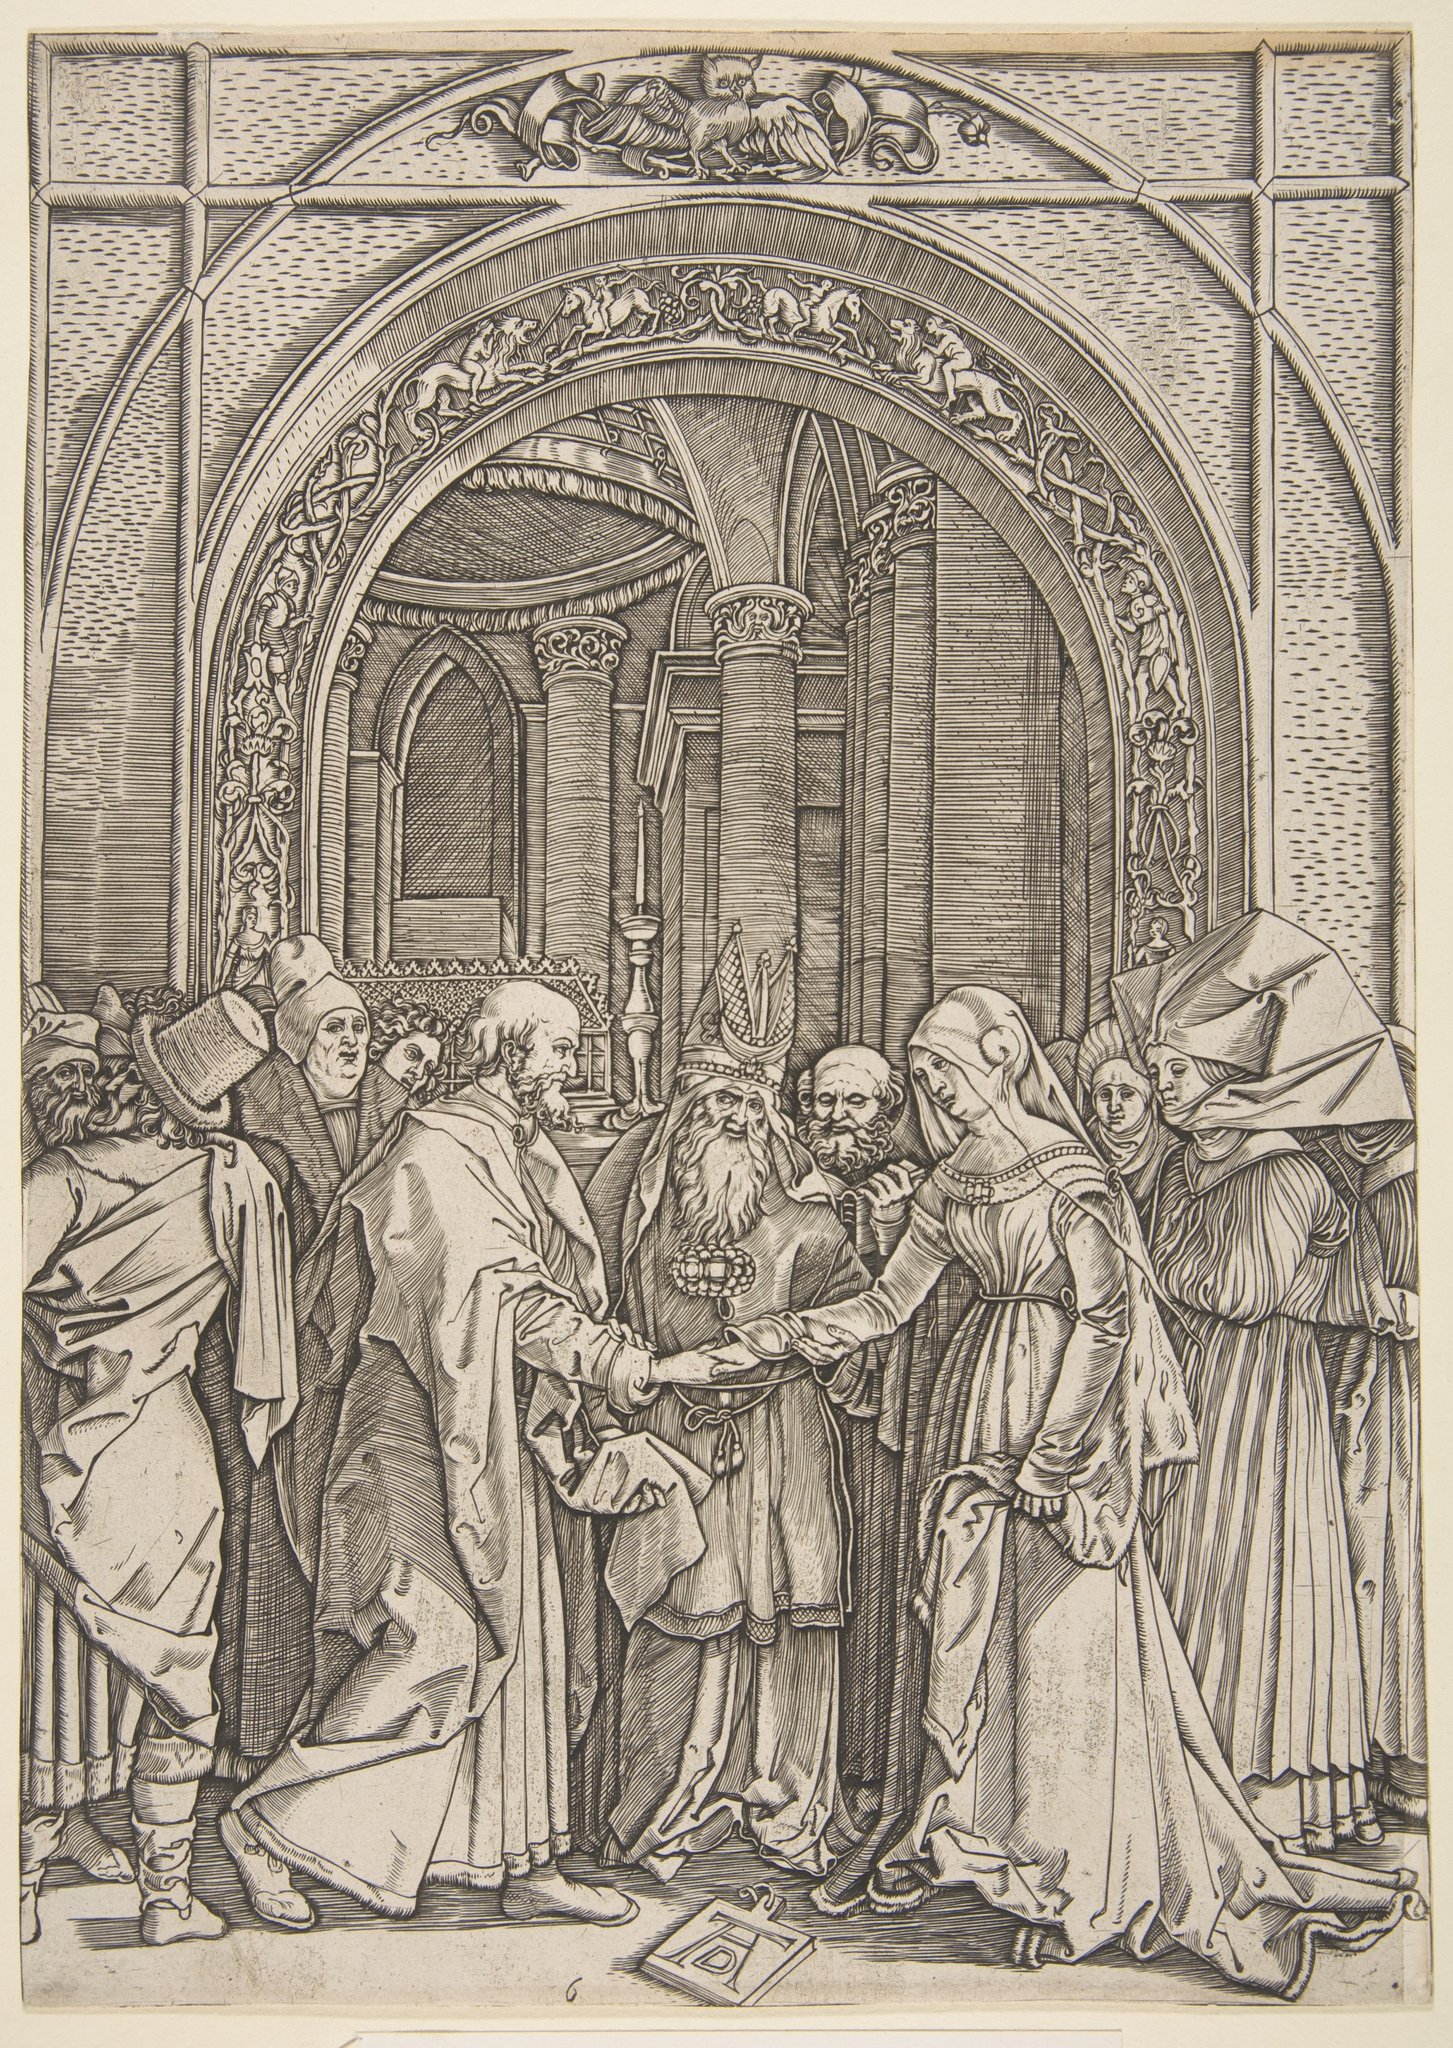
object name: print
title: The Betrothal of the Virgin, from "The Life of the Virgin" (copy)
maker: albrecht dürer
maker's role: artist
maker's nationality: german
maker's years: 1471-1528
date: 1501-1533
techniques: engraving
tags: men,women,virgin mary